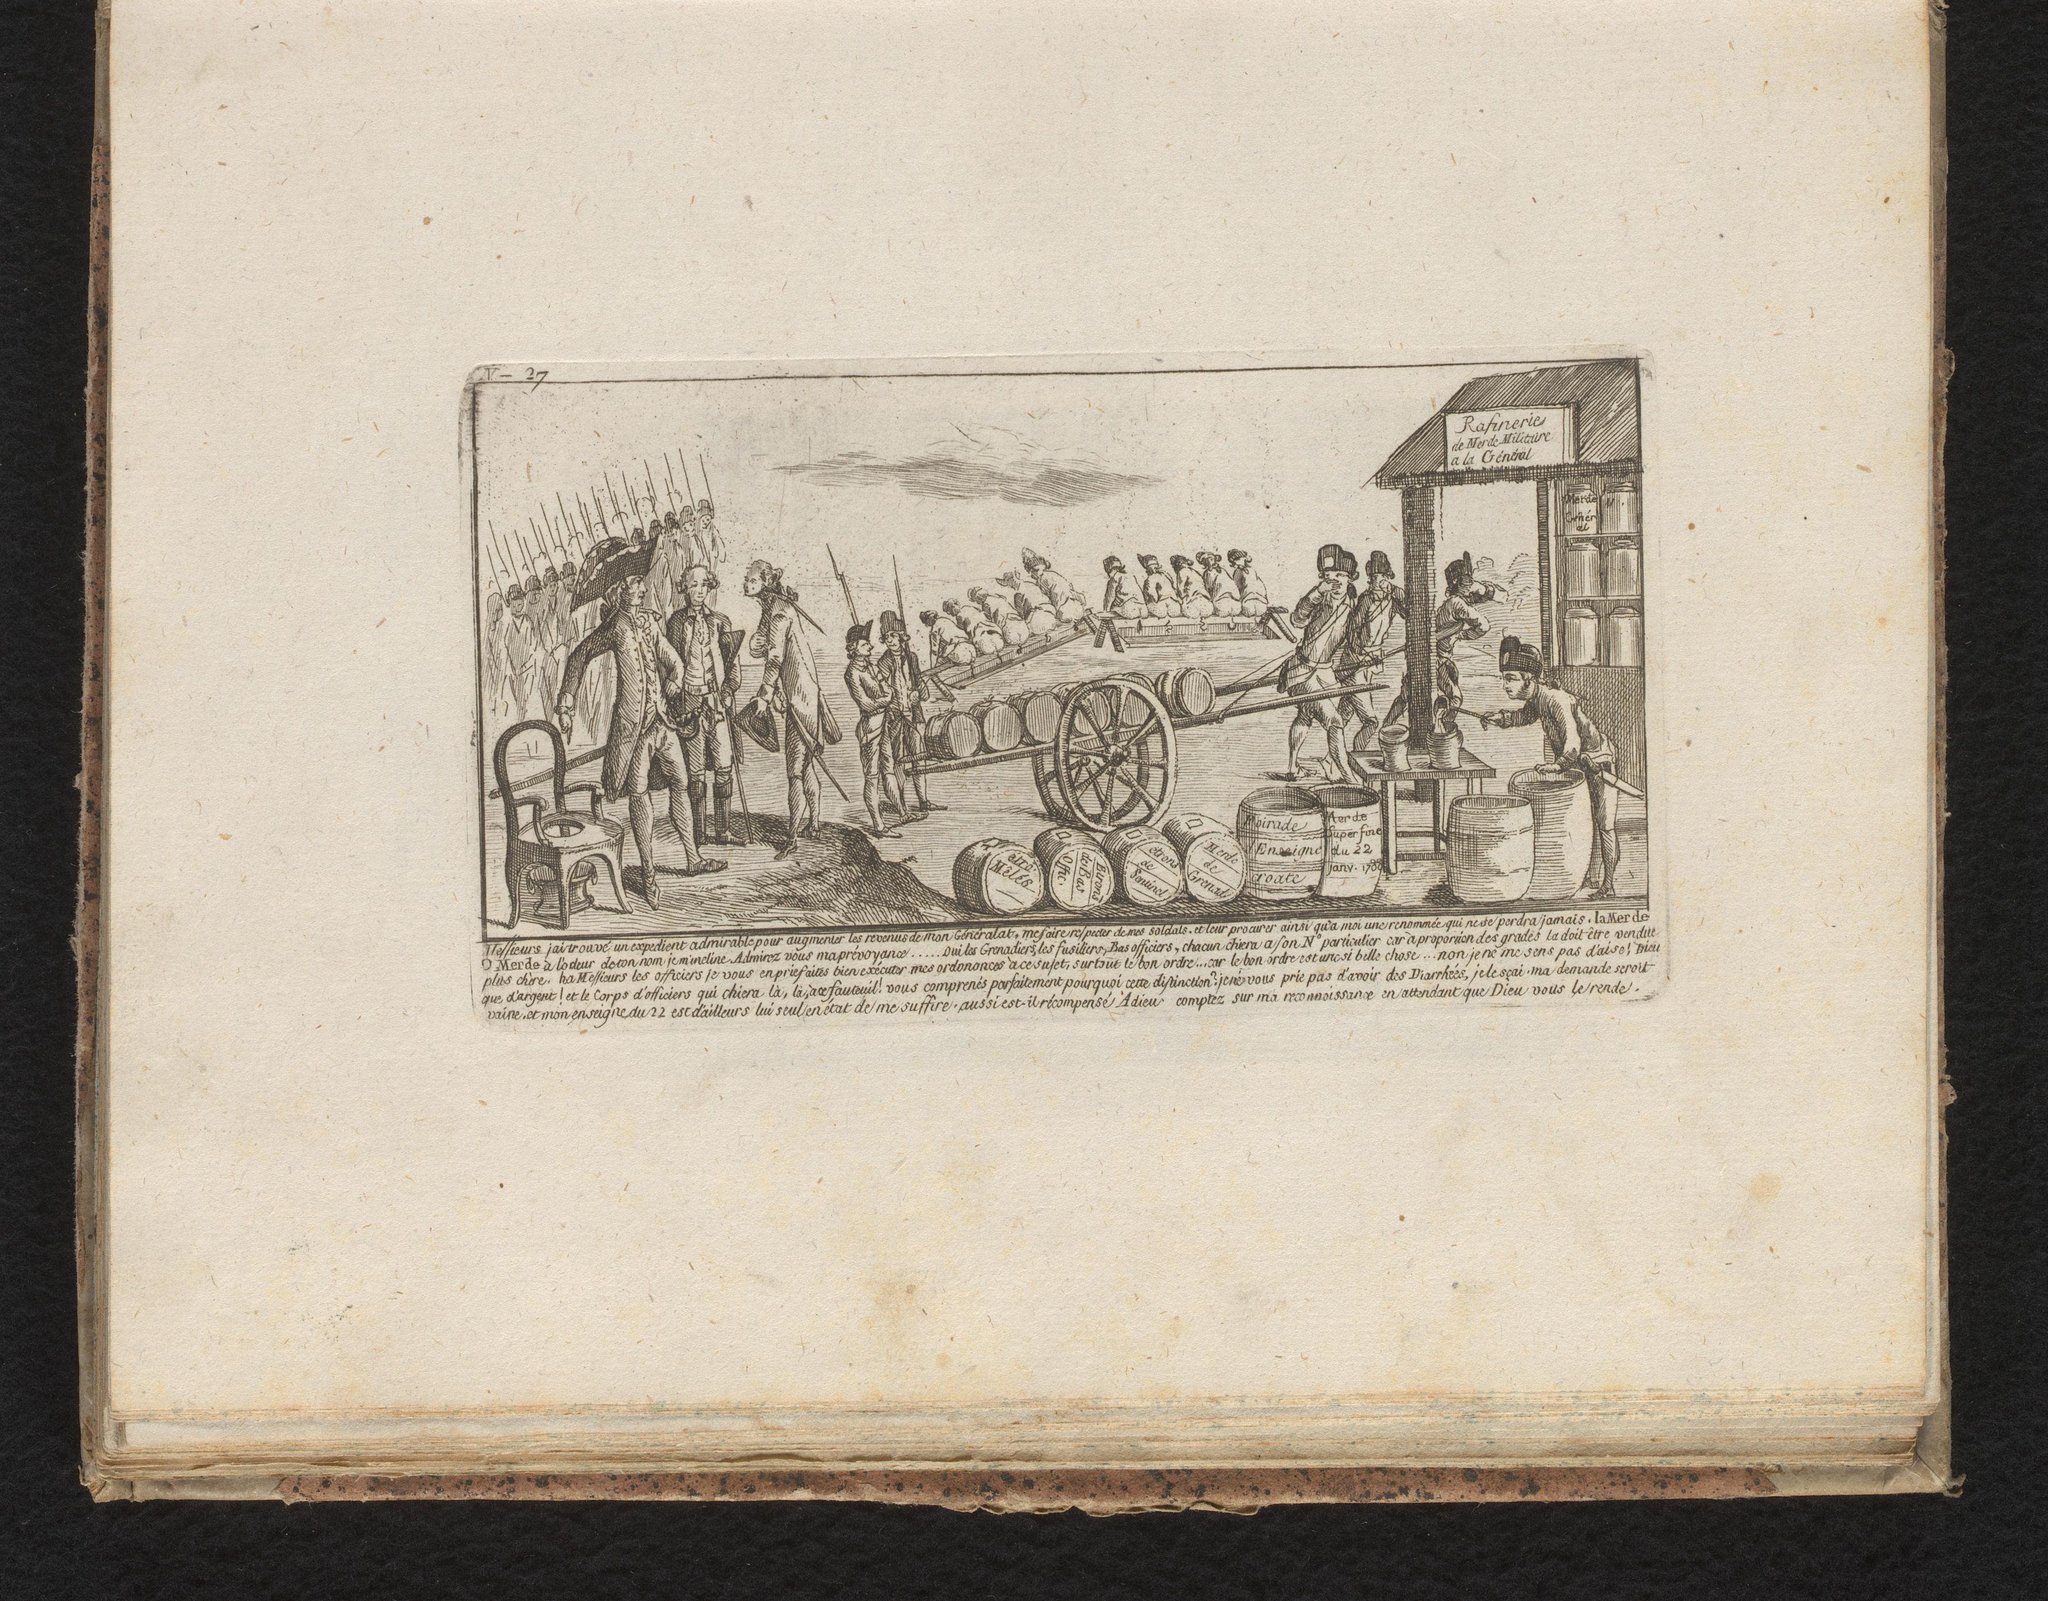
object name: cartoon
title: Spotprent op generaal d'Alton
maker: Anonymous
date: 1787-1790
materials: paper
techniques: engraving, etching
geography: southern netherlands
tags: defecation, brussels, brabant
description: Spotprent op de Oostenrijkse generaal d'Alton. De uitwerpselen van Oostenrijkse soldaten worden opgevangen en in tonnen bewaard. Links de generaal bij een kakstoel. Ook in verband met de schietpartij te Brussel op 22 januari 1788. Met Frans onderschrift van 5 regels. Linksboven genummerd: No. 27. Onderdeel van de gebundelde verzameling prenten betrekking hebbend op de gebeurtenissen van de Brabantse Omwenteling en de periode 1787-1790.